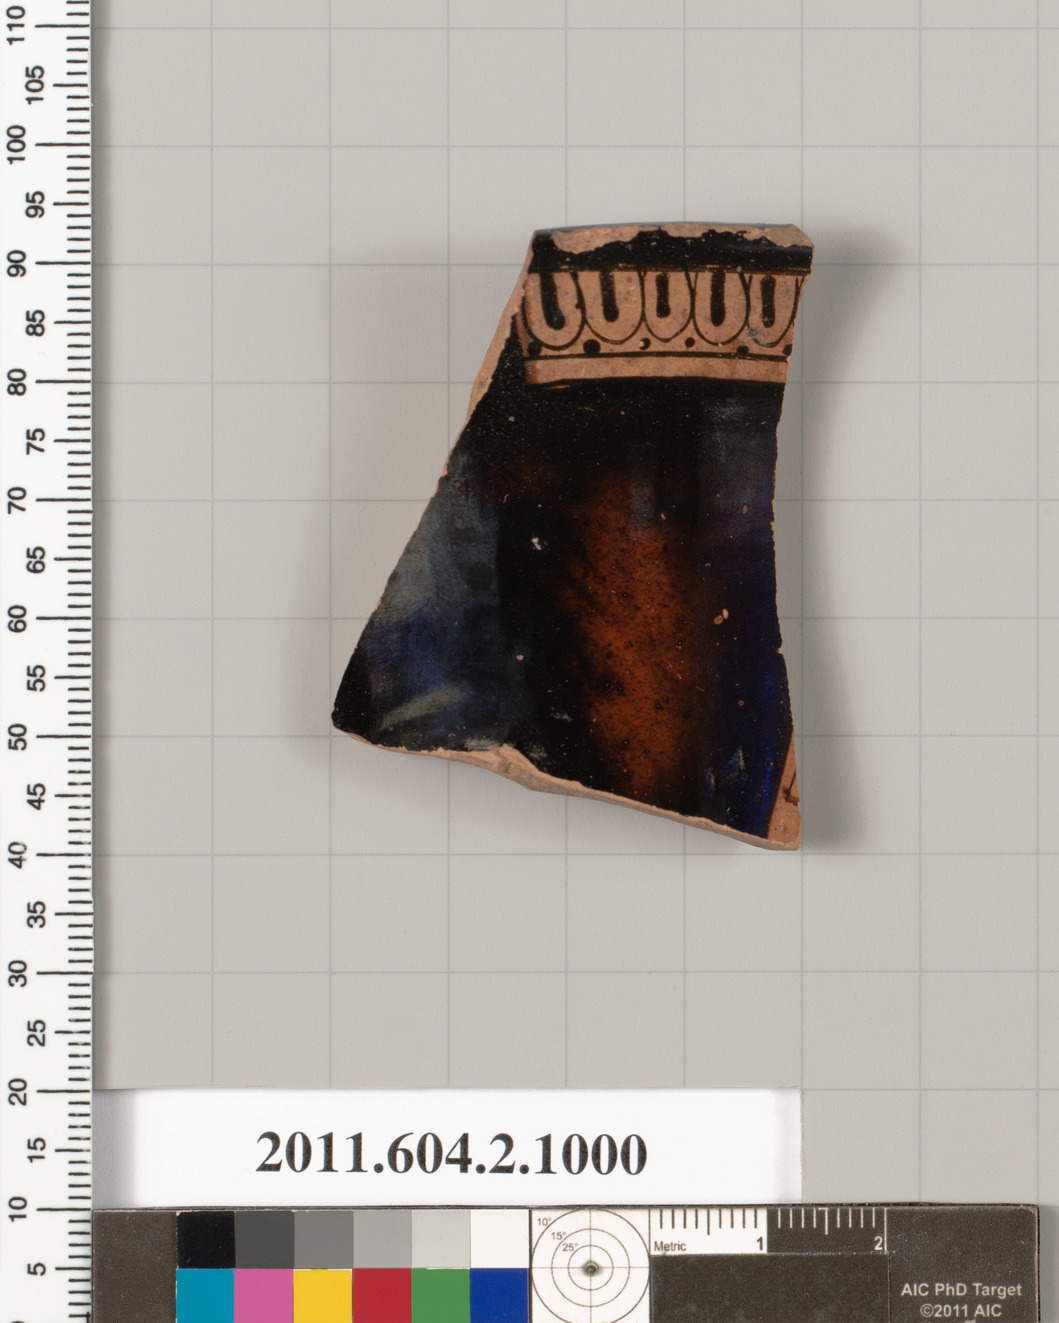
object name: olpe fragment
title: Terracotta fragment of an oinochoe: olpe (jug)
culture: greek, attic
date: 467-435 BCE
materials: terracotta